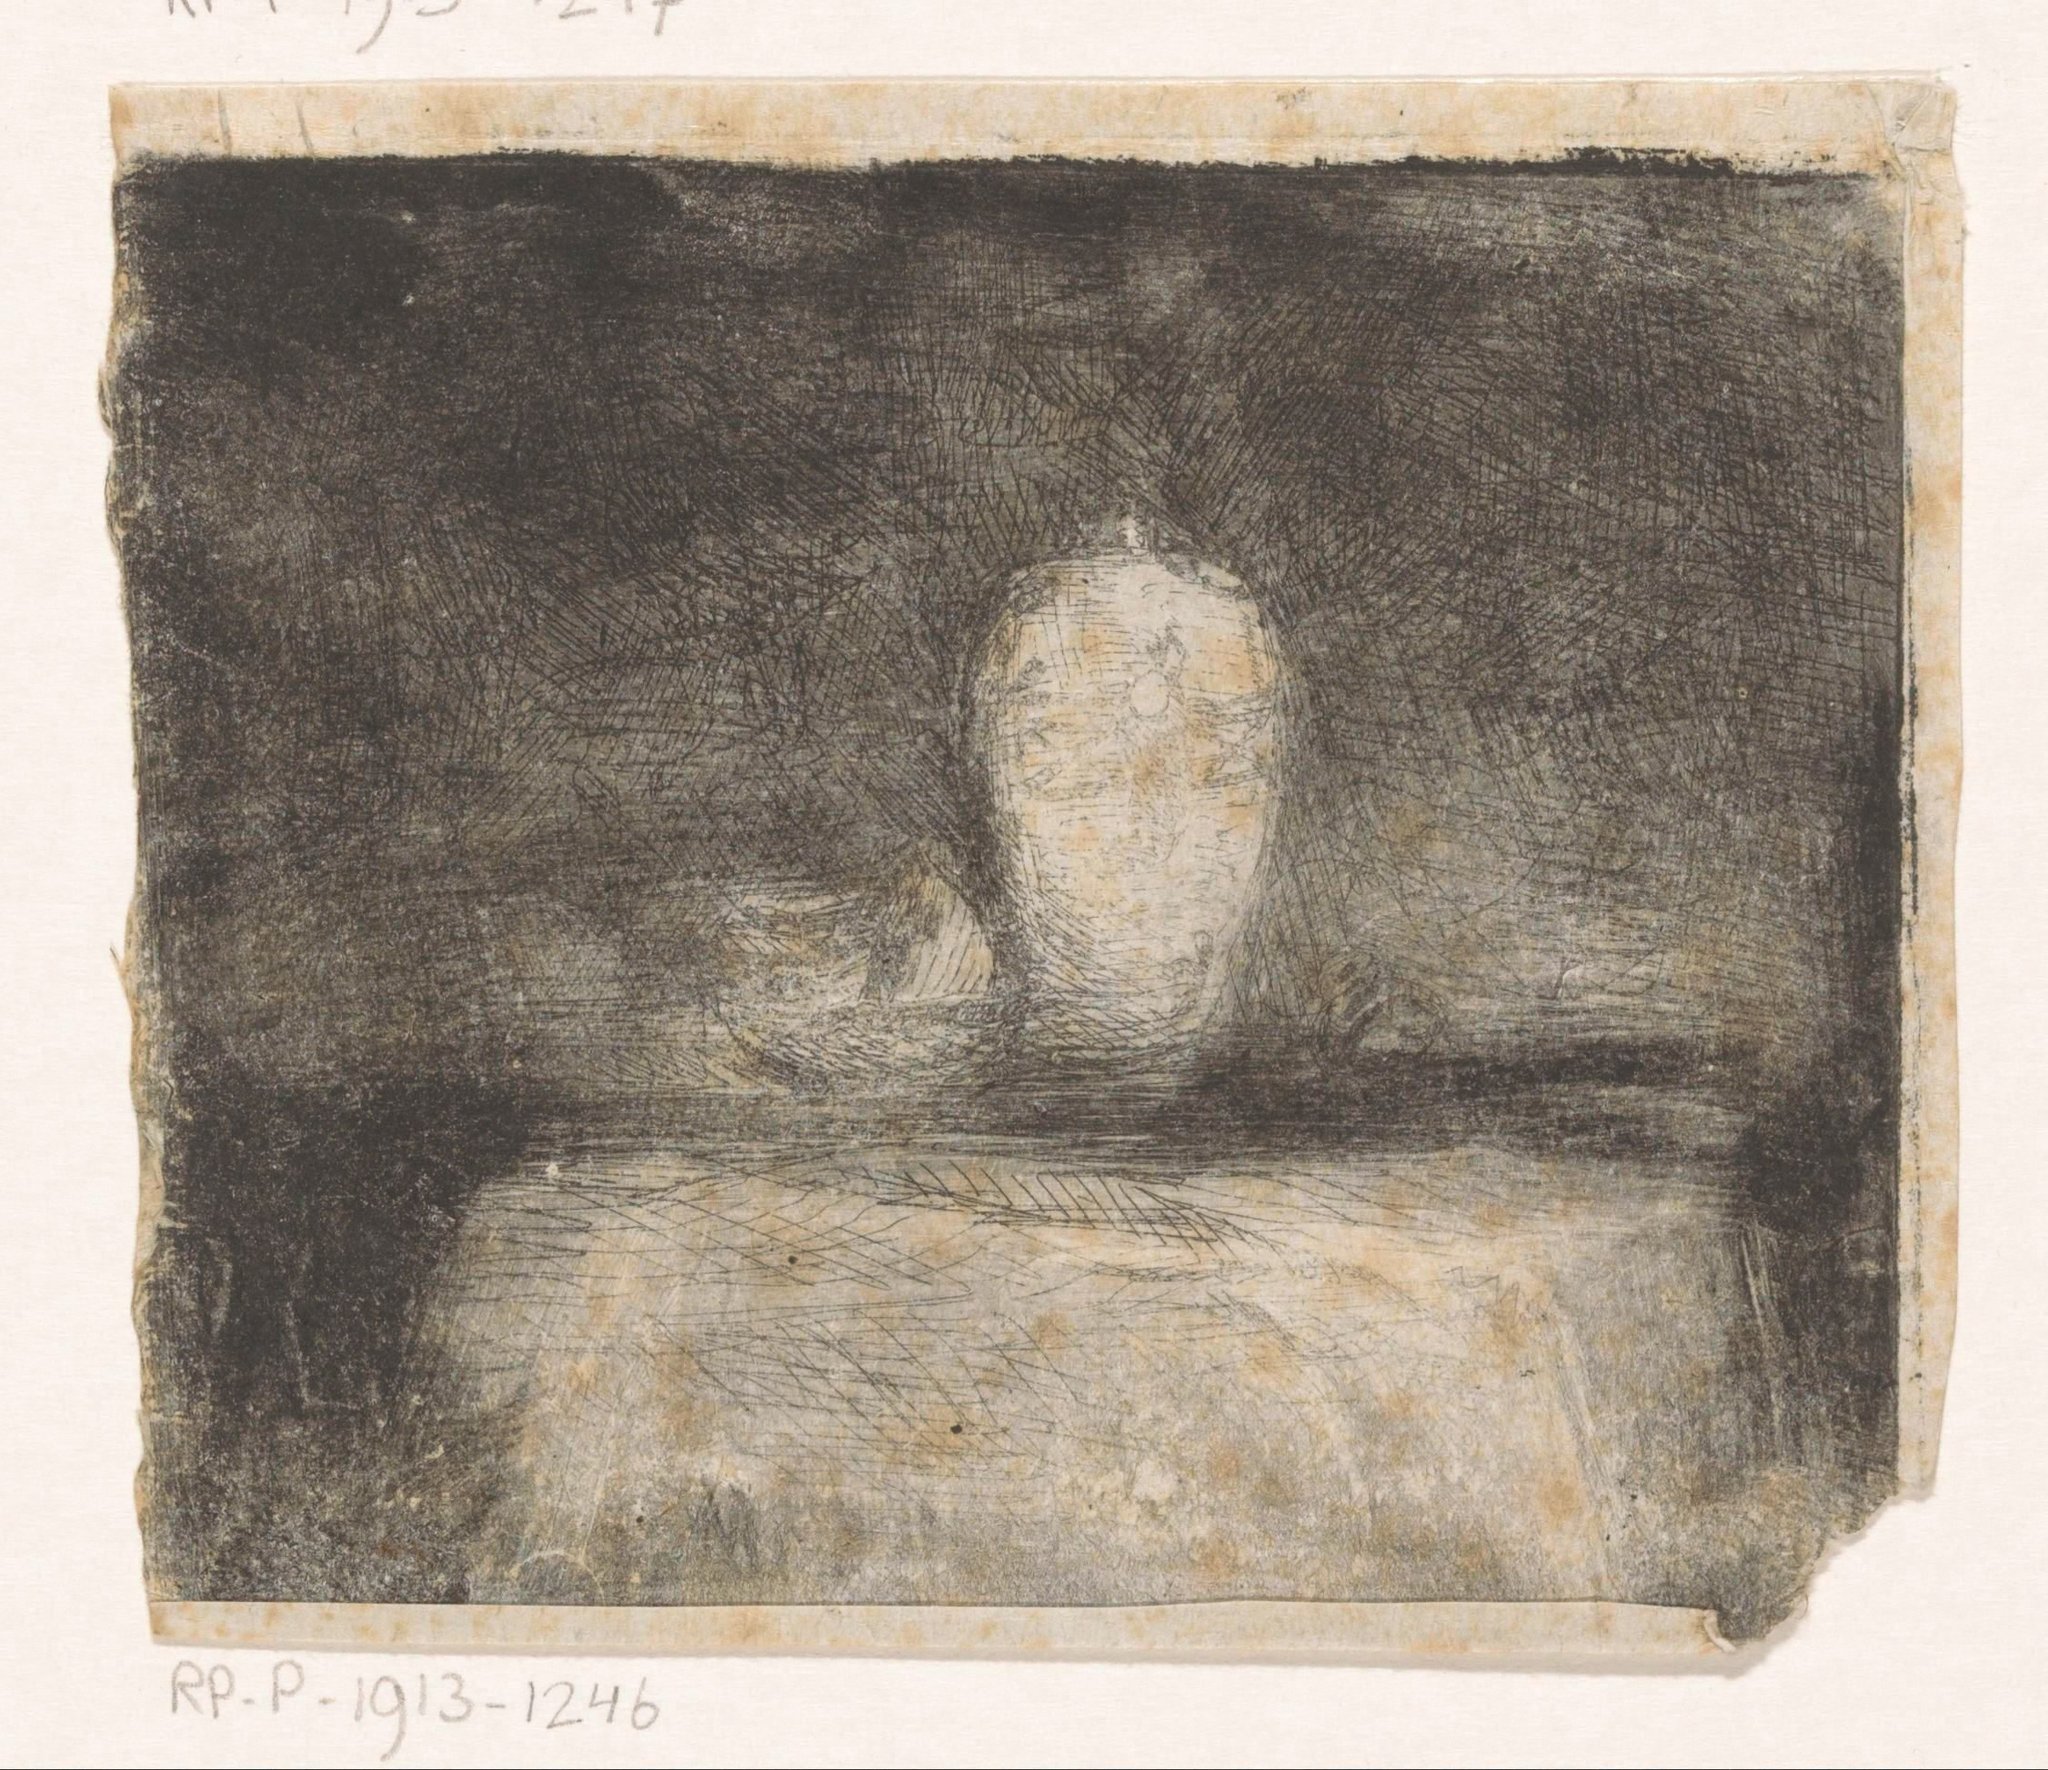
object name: print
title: Stilleven met vaas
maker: marinus van der maarel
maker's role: draughtsman, painter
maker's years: 1857-1921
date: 1867-1913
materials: paper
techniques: etching, intaglio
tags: still life of related objects, container of ceramics: jar, jug, pot, vase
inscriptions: collector's mark: Lugt 2228, collector's mark: Lugt 2233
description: Op de vaas een figuur voor een hek. Links een stapel kommen.